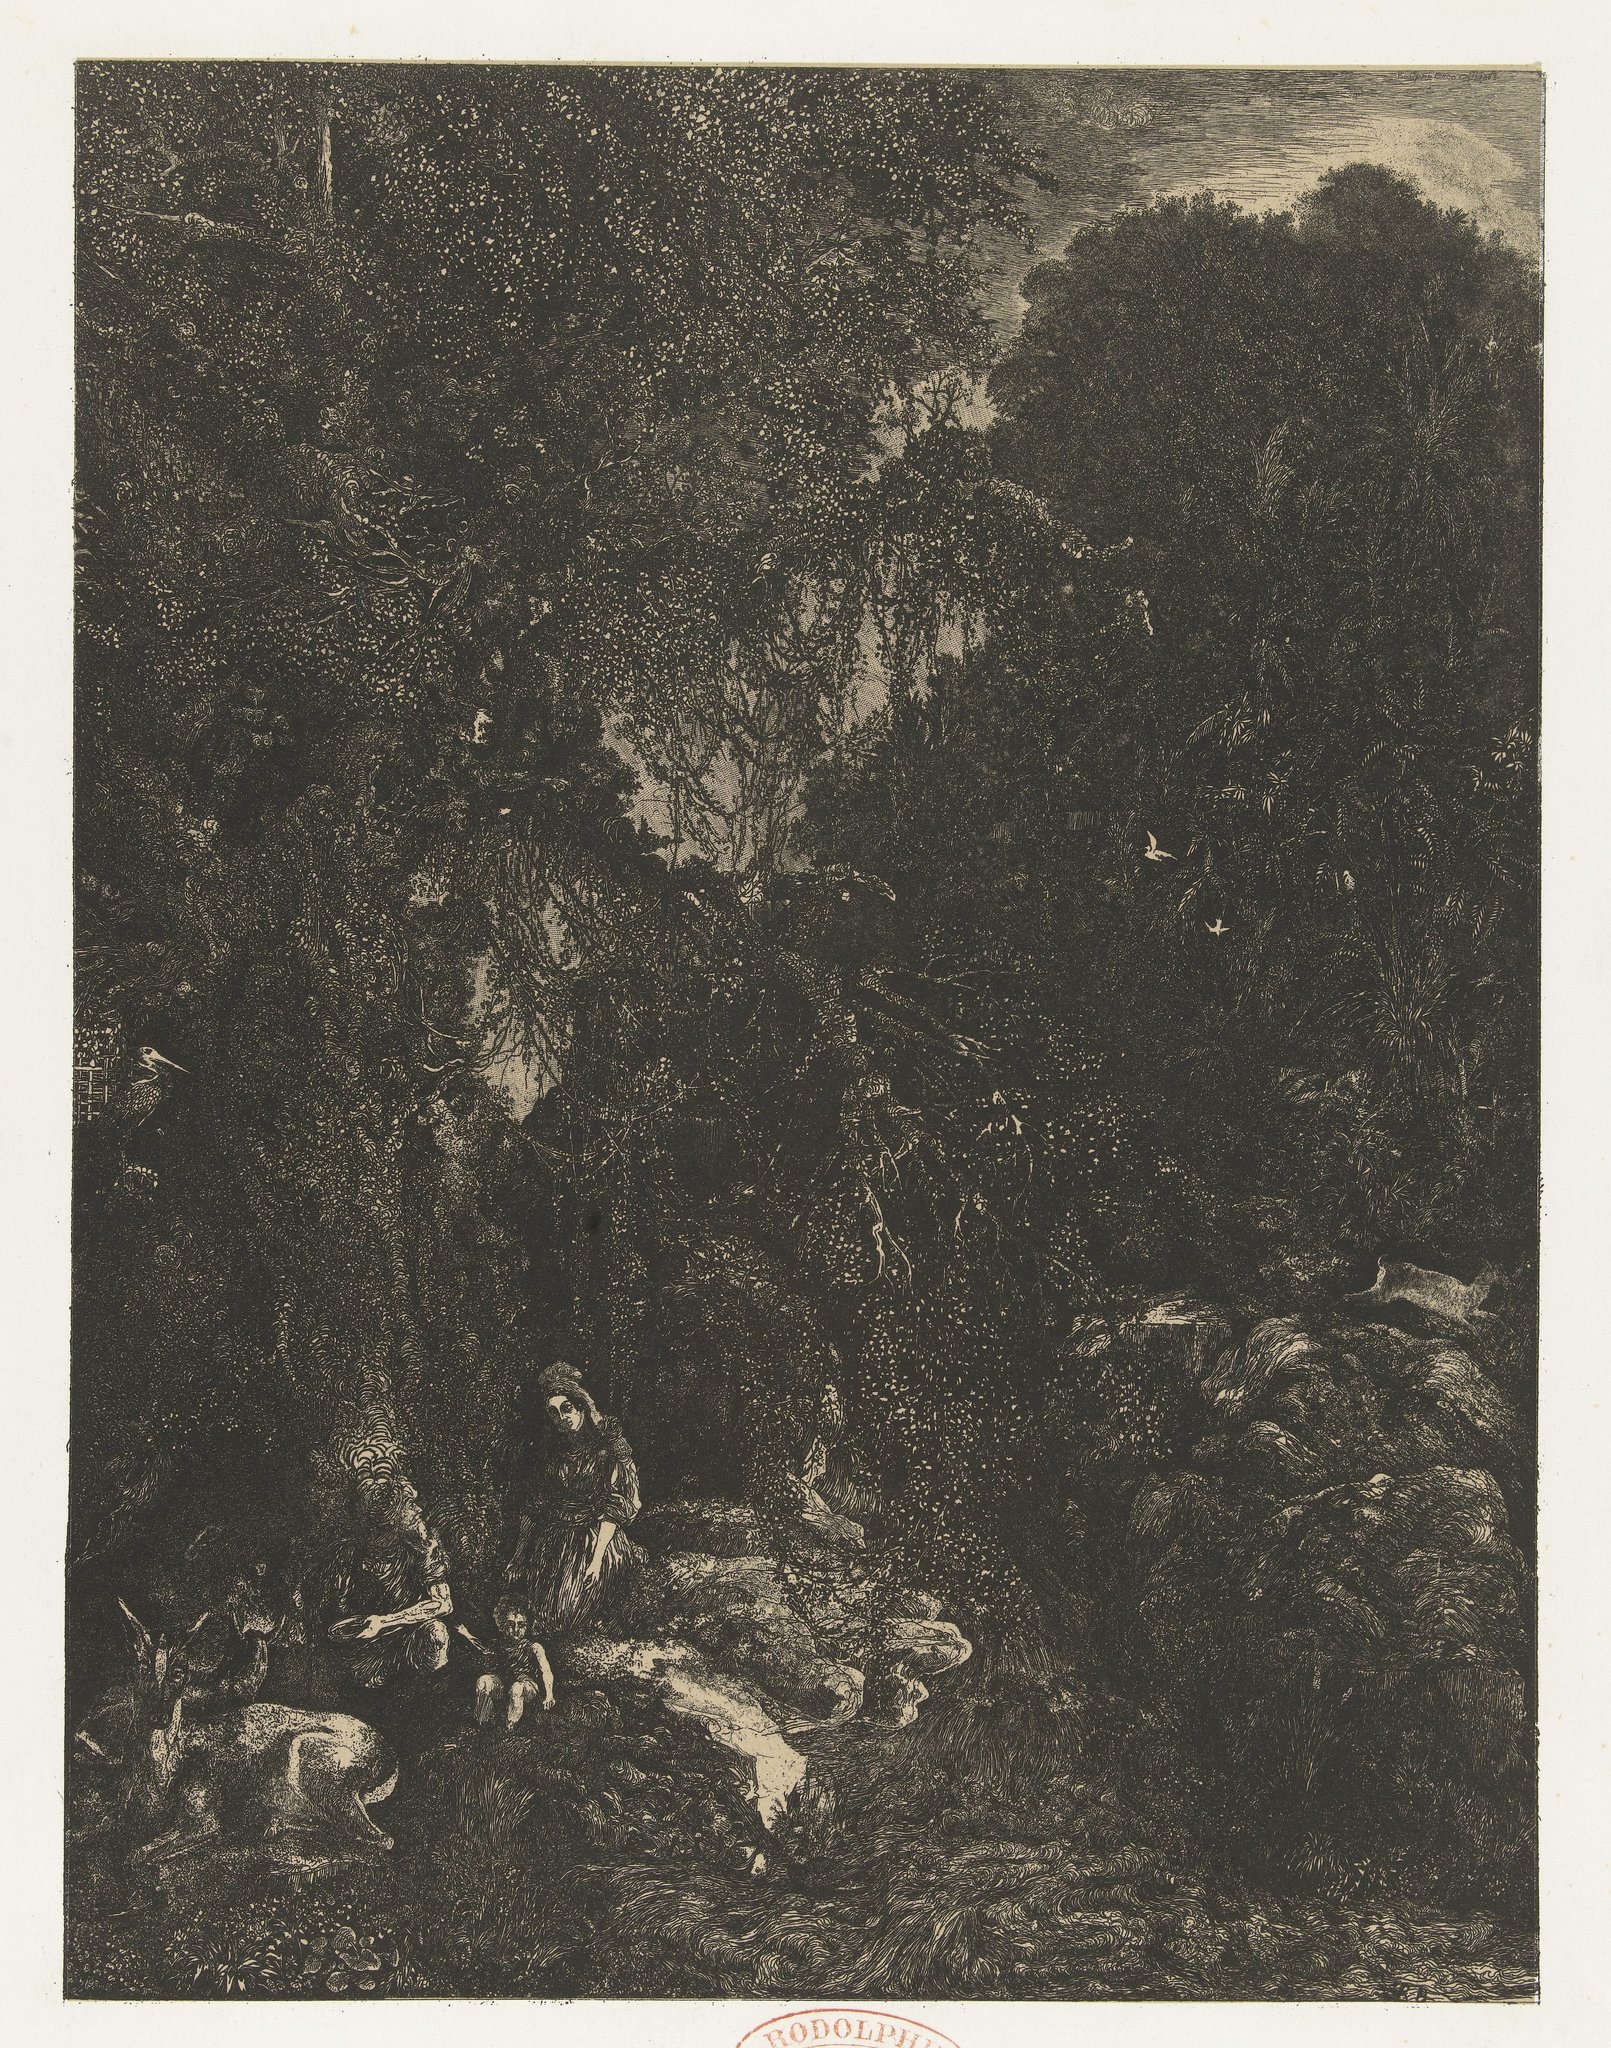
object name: print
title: Rest on the Flight into Egypt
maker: rodolphe bresdin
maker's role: draughtsman, print maker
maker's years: 1822-1885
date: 1871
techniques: printmaking, lithograph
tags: rest on the flight into egypt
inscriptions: collector's mark: Lugt 2233, collector's mark: Lugt 295b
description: Landschap met Maria en kind en Jozef tijdens de rust op de vlucht naar Egypte. Zij zitten samen met de ezel op de rotsachtige oever van een beek onder een grote boom. De bomen en planten zijn gedetailleerd uitgewerkt waardoor de dieren die zijn weergegeven bijna volledig opgaan in deze omgeving.